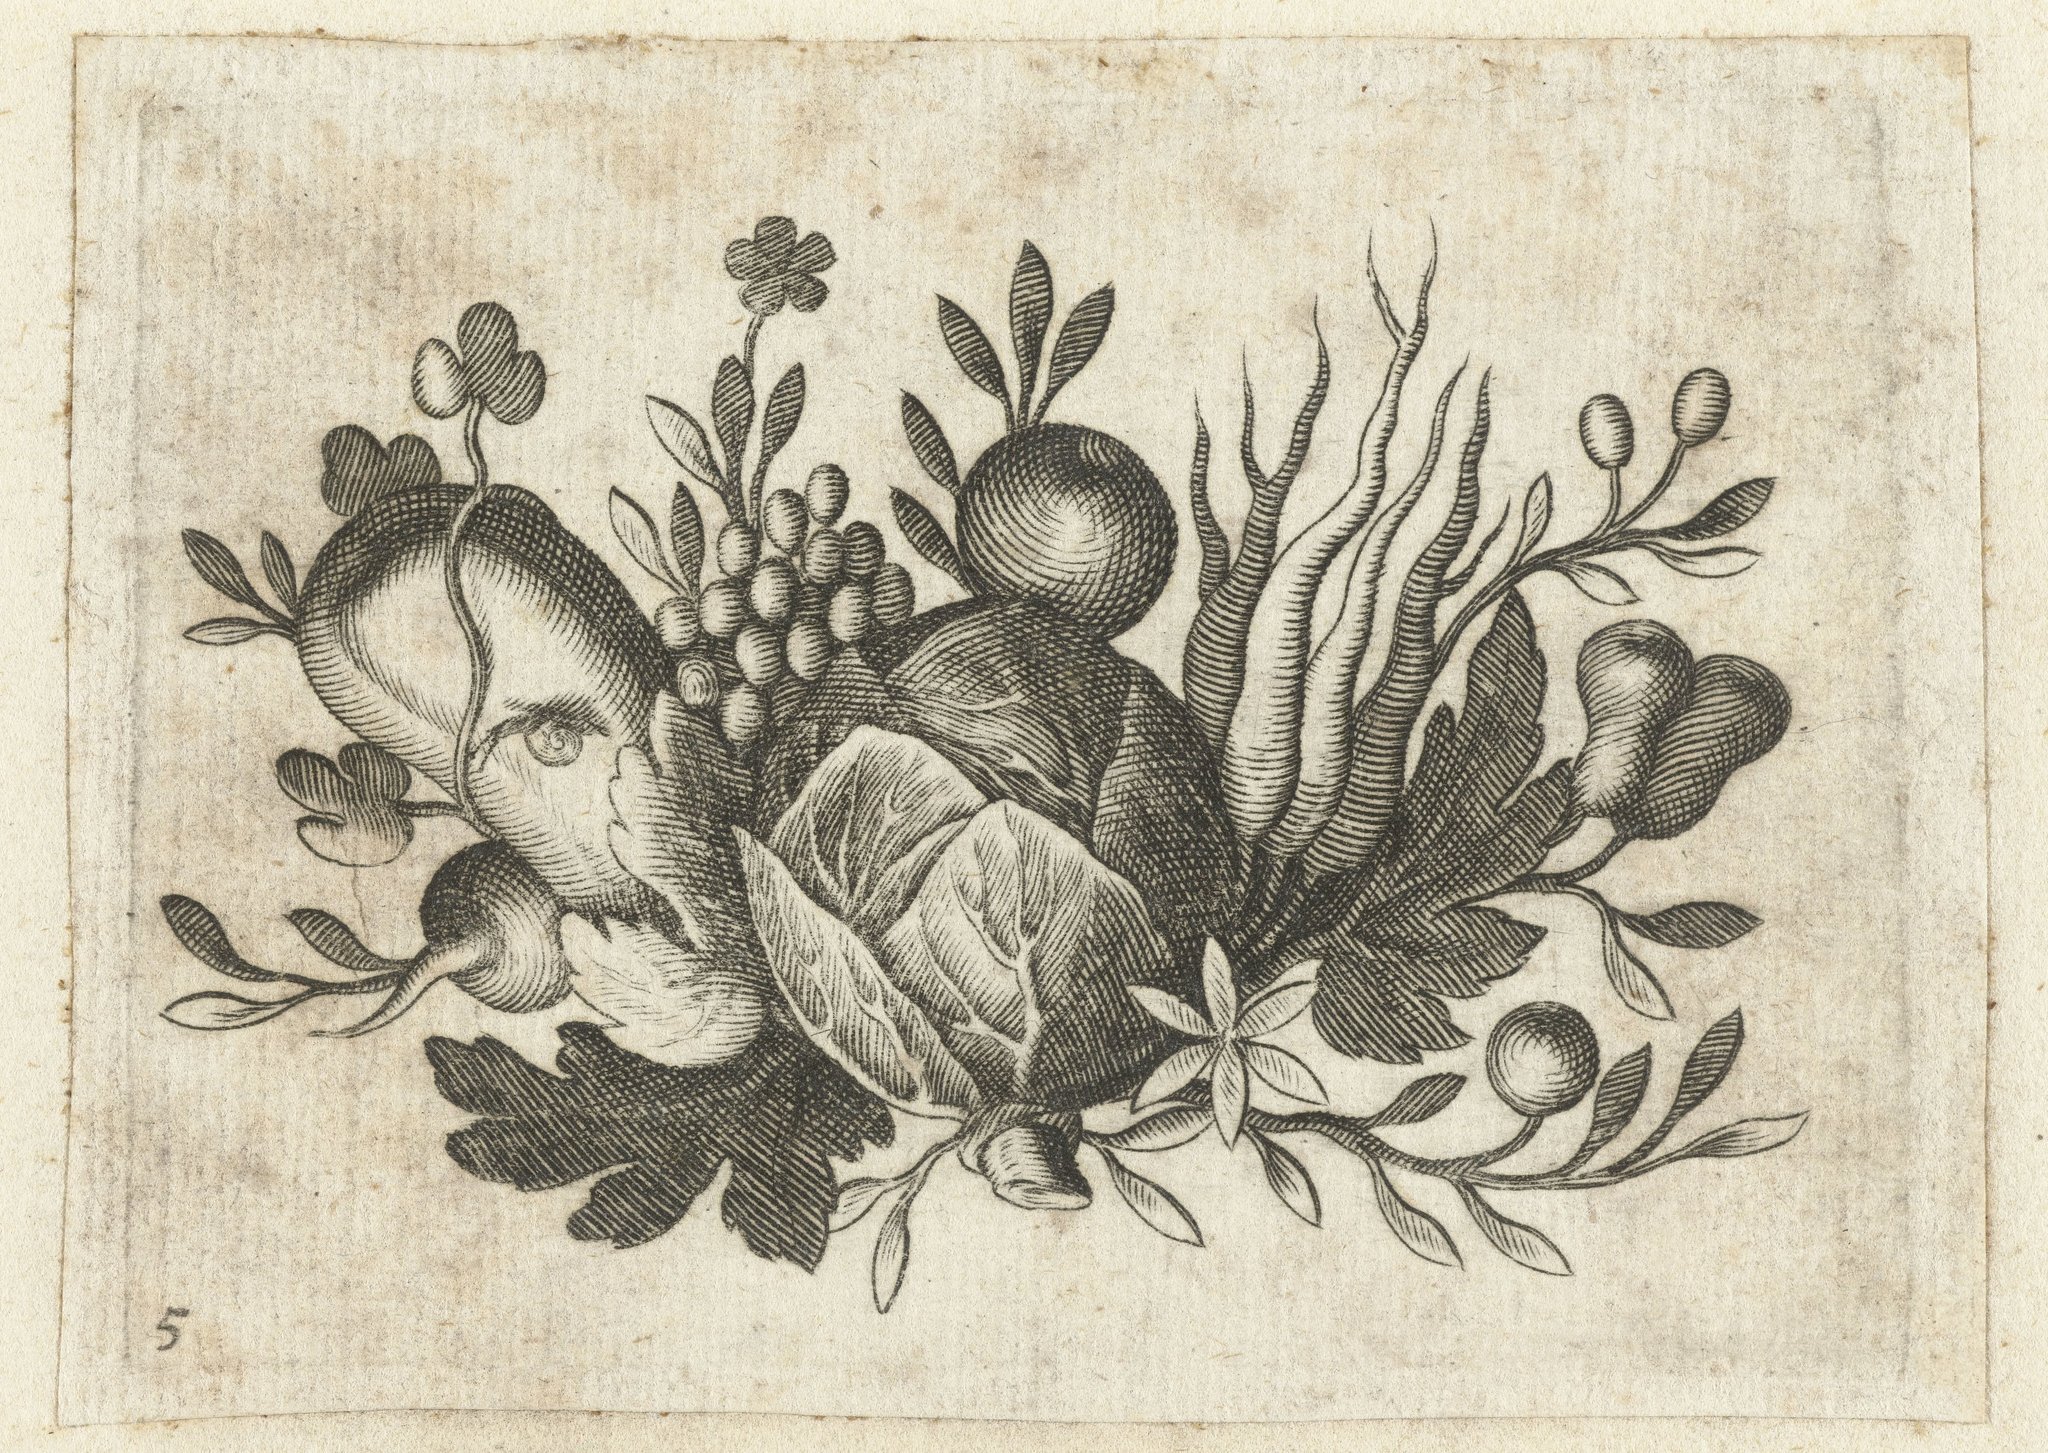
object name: ornament print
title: Fruchtenbuchlein zum Reisen dienlich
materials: paper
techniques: engraving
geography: germany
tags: fruits and vegetables ~ ornament, ornament ~ festoon, garland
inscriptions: number: ‘5’